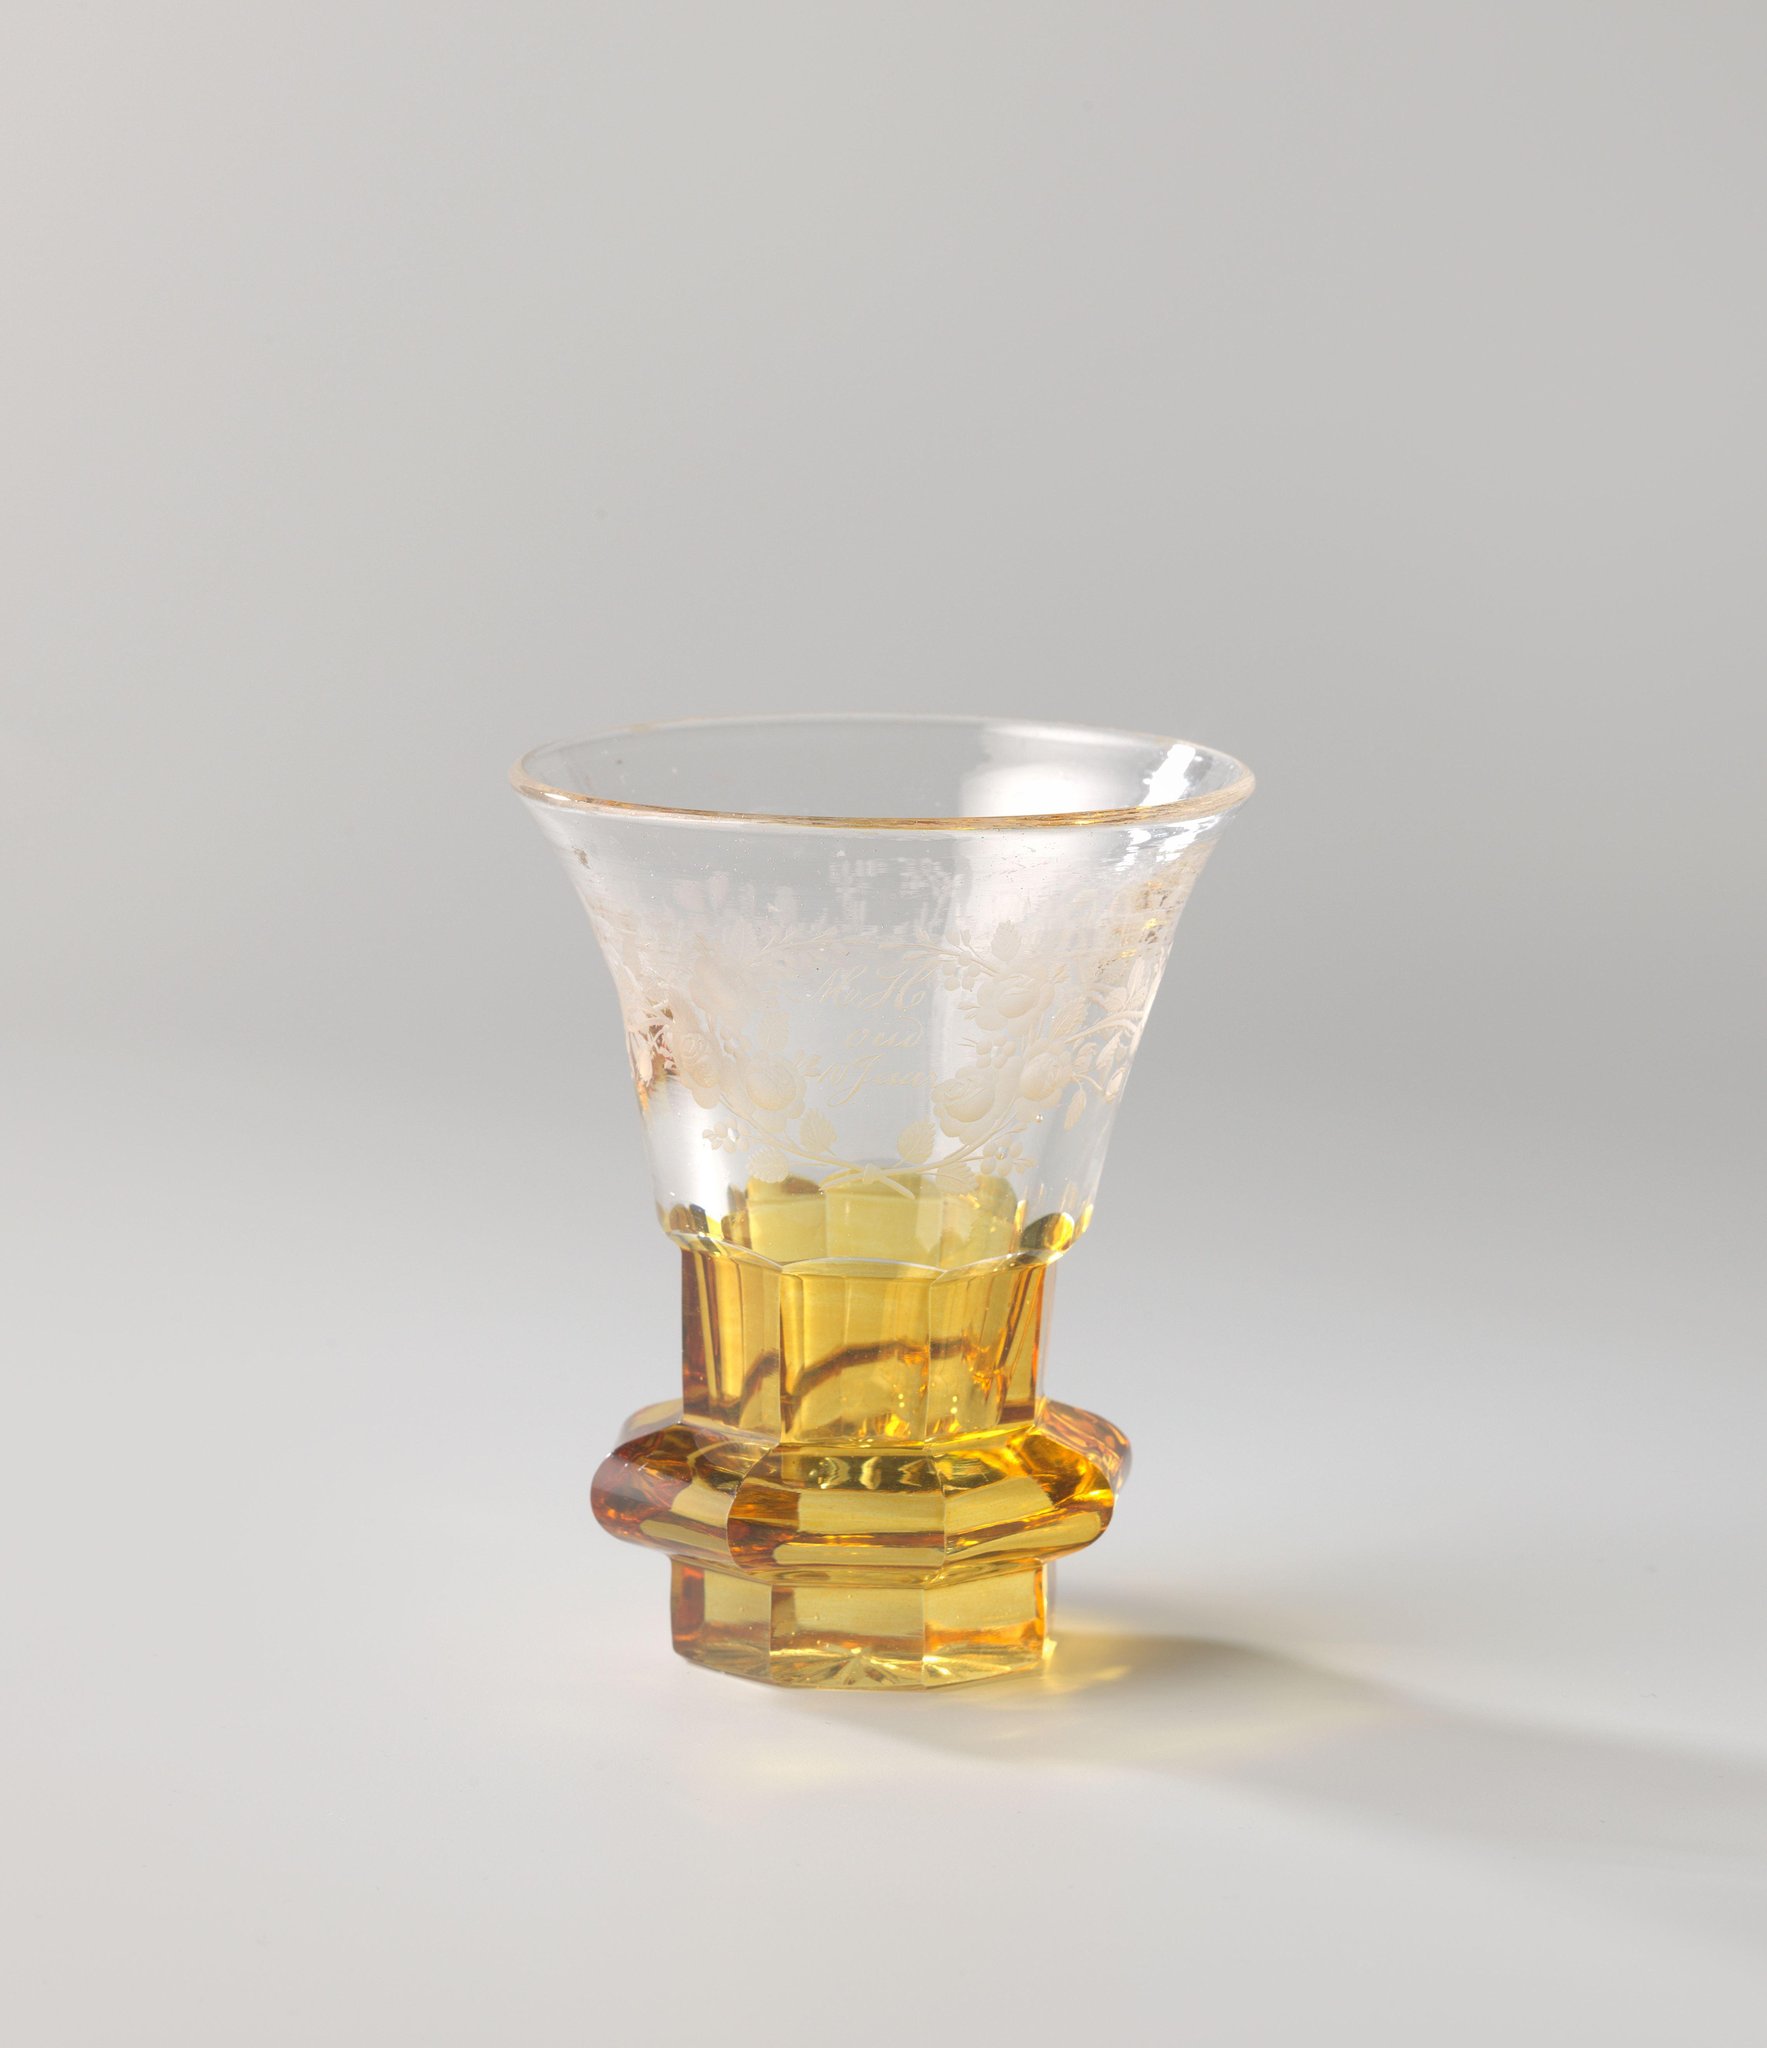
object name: ranftbecher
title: Ranftbecher met bloemtakken en opschrift: MH oud 10 Jaar.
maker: Anonymous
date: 1830-1850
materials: glass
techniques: glassblowing, grinding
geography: northern netherlands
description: Ranftbecher met achthoekige voet en nodus. Het onderste deel van de kelk met gele Überfang. Op de kelk gegraveerde bloemtakken en het opschrift: MH oud 10 Jaar.